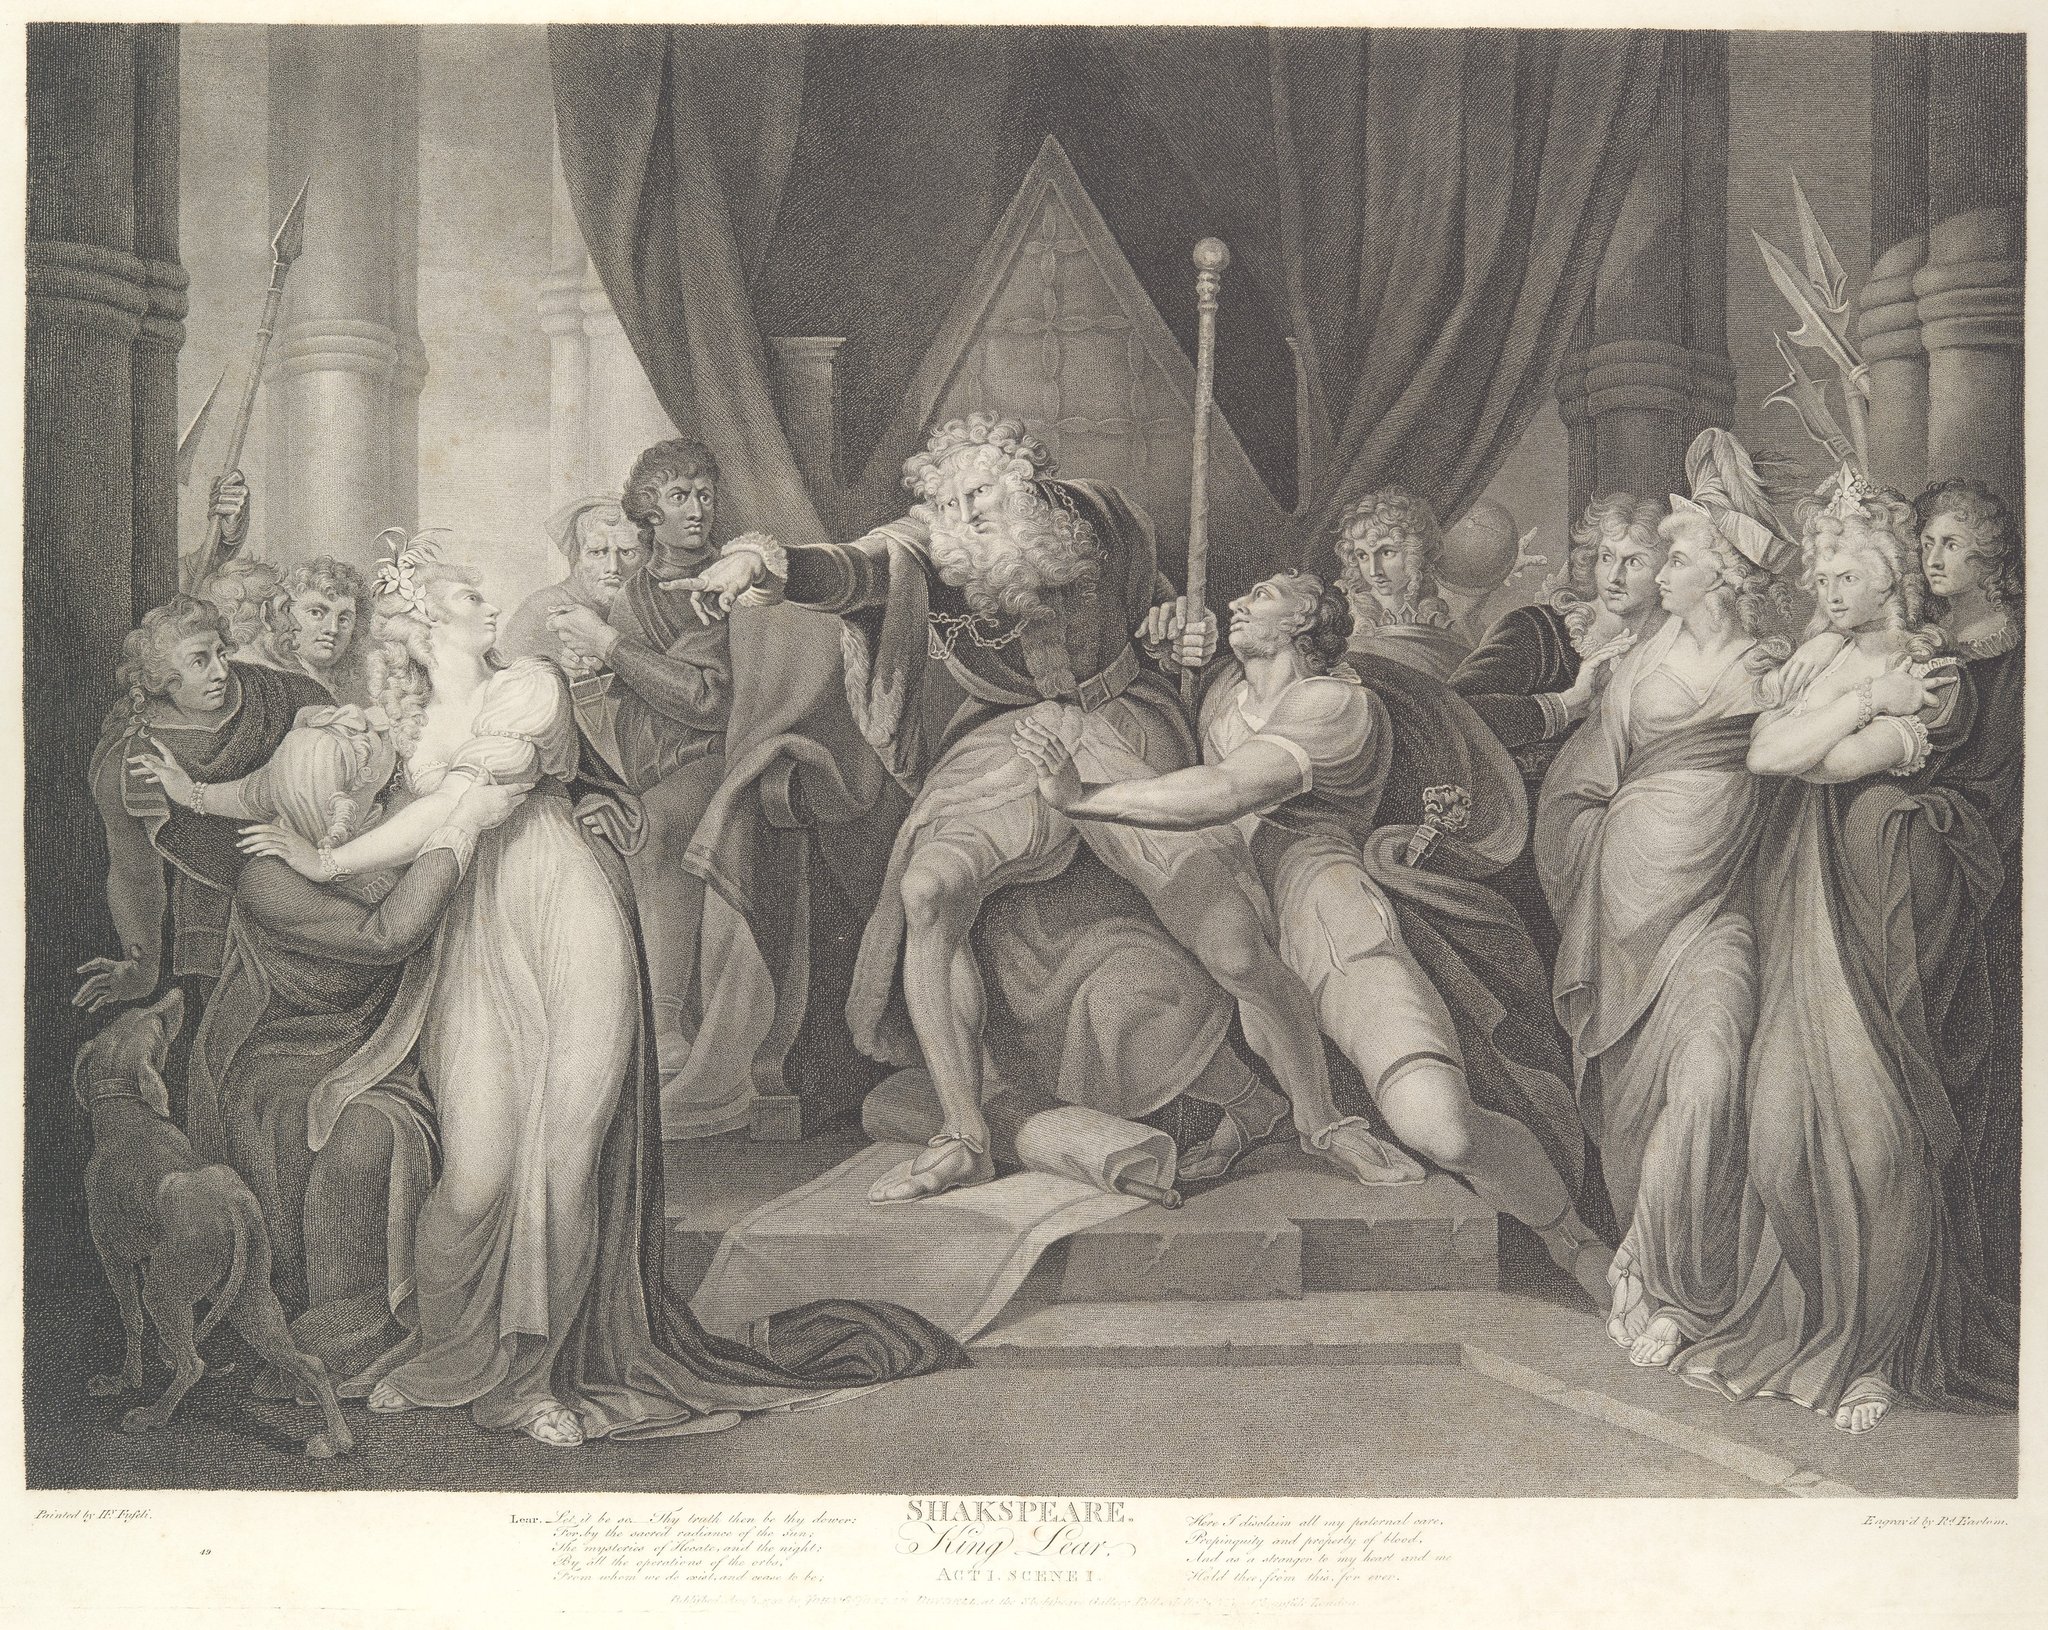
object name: print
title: King Lear Casting Out His Daughter Cordelia (Shakespeare, King Lear, Act 1, Scene 1)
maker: richard earlom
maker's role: engraver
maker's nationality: british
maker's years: 1743-1822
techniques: engraving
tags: kings,shakespeare,men,fathers,women,dogs,king lear